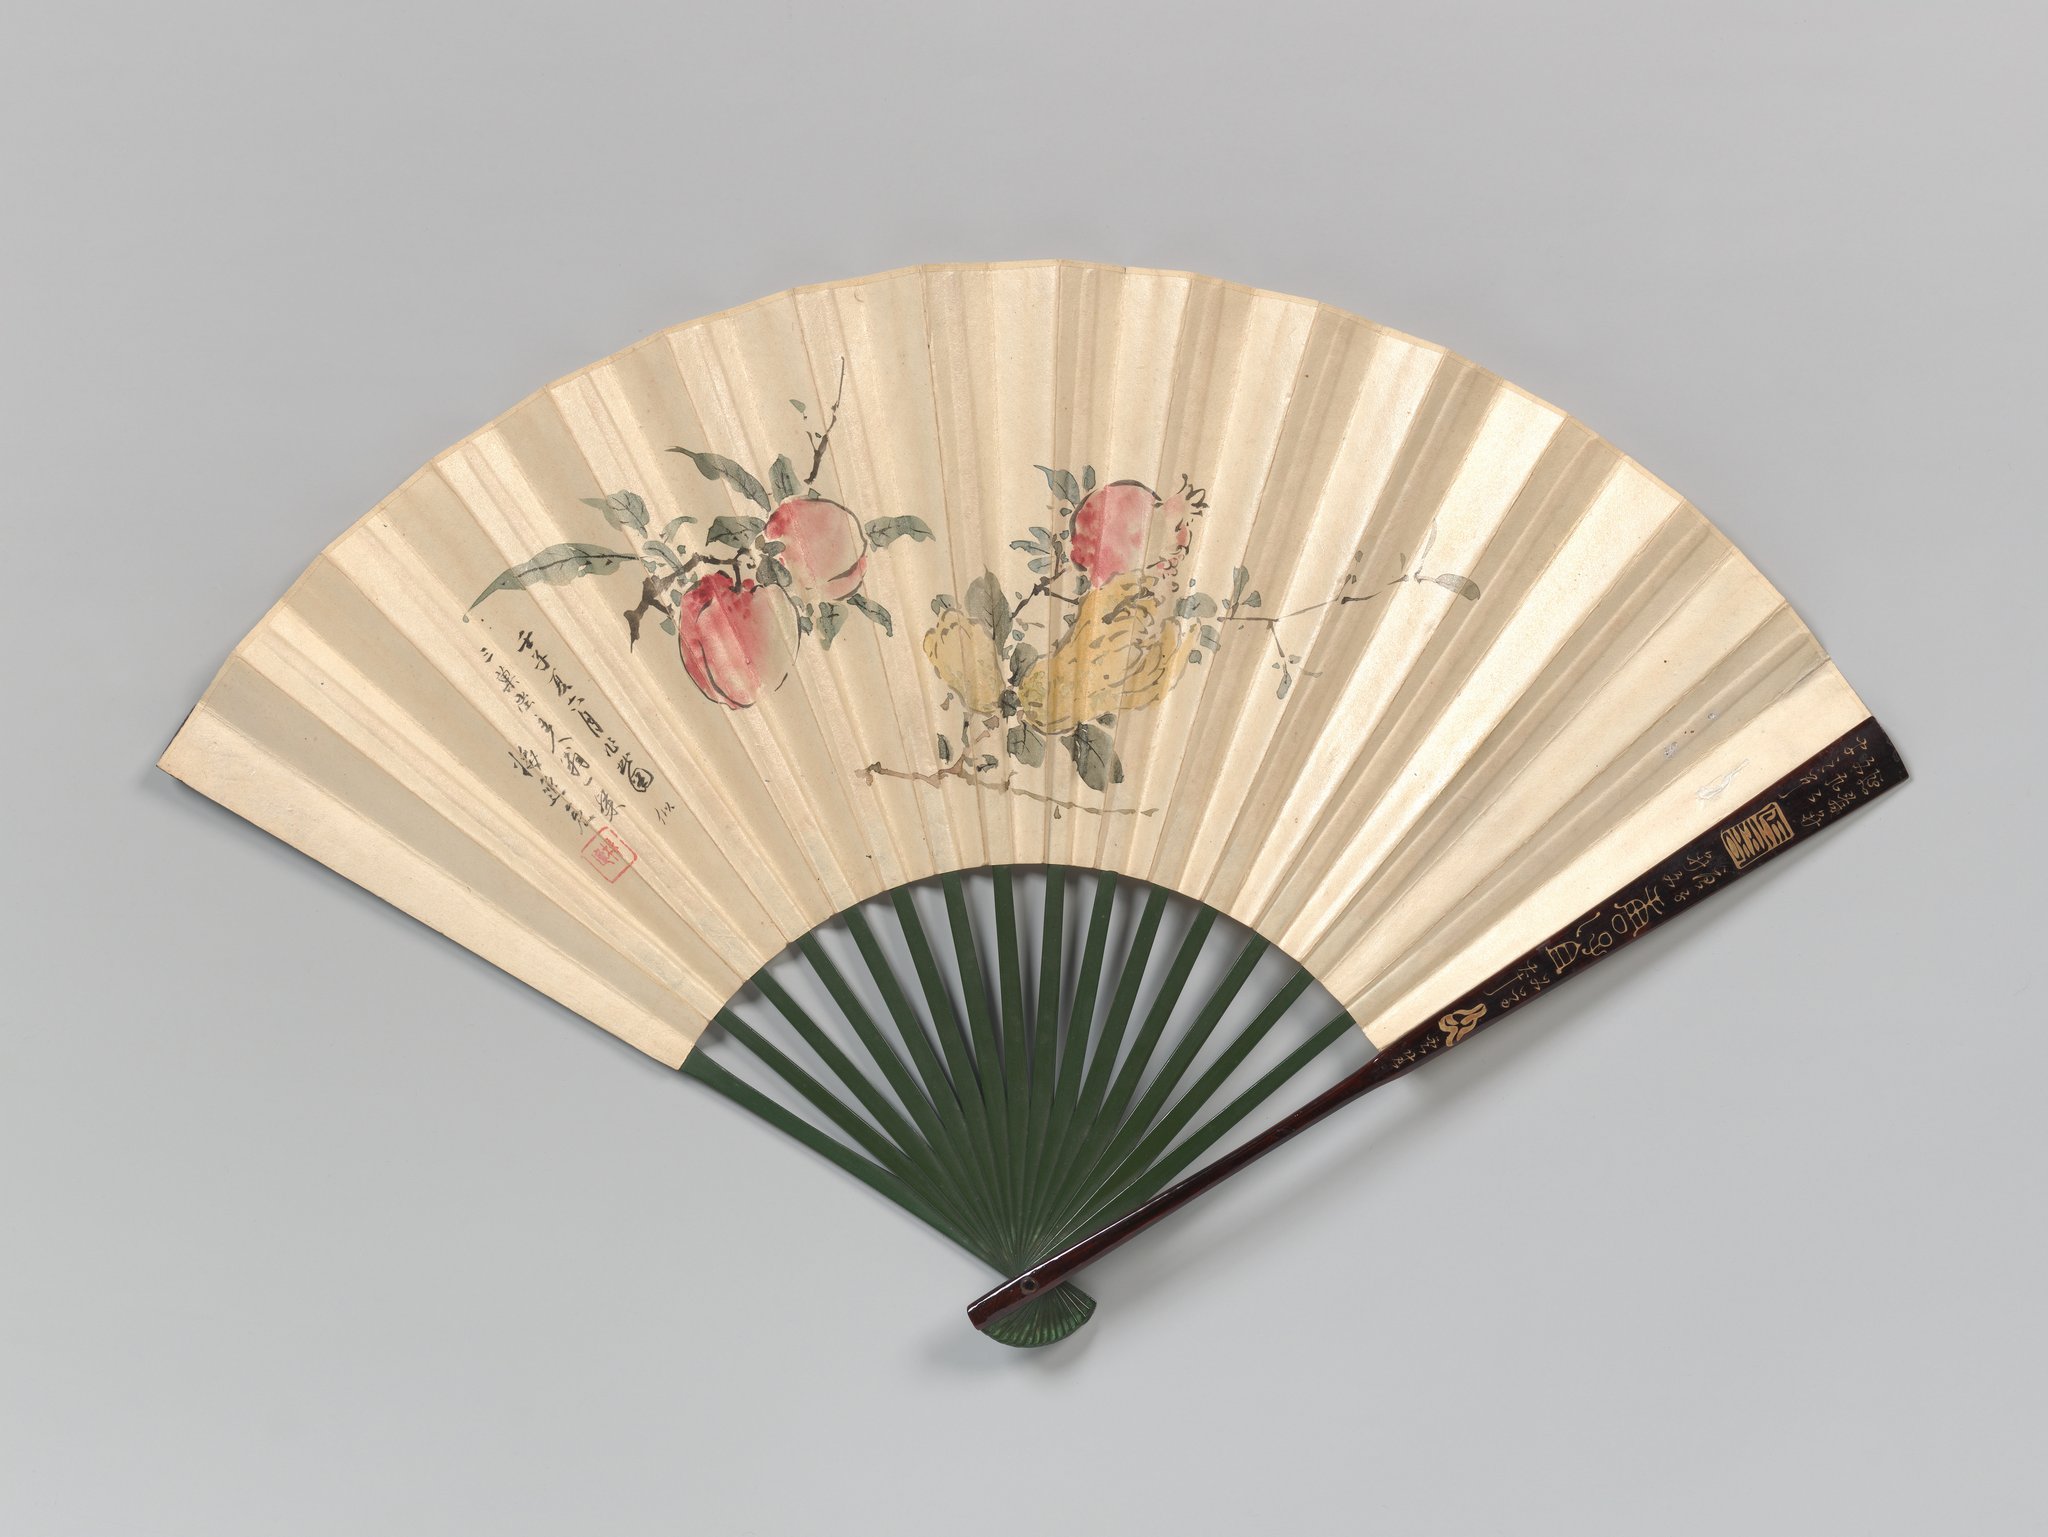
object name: folding fan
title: Peaches, Pomegranate, and Fingered Citron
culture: japanese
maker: yamamoto baiitsu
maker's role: artist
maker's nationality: japanese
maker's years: 1783-1856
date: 1832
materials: ink, paper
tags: peaches,pomegranates